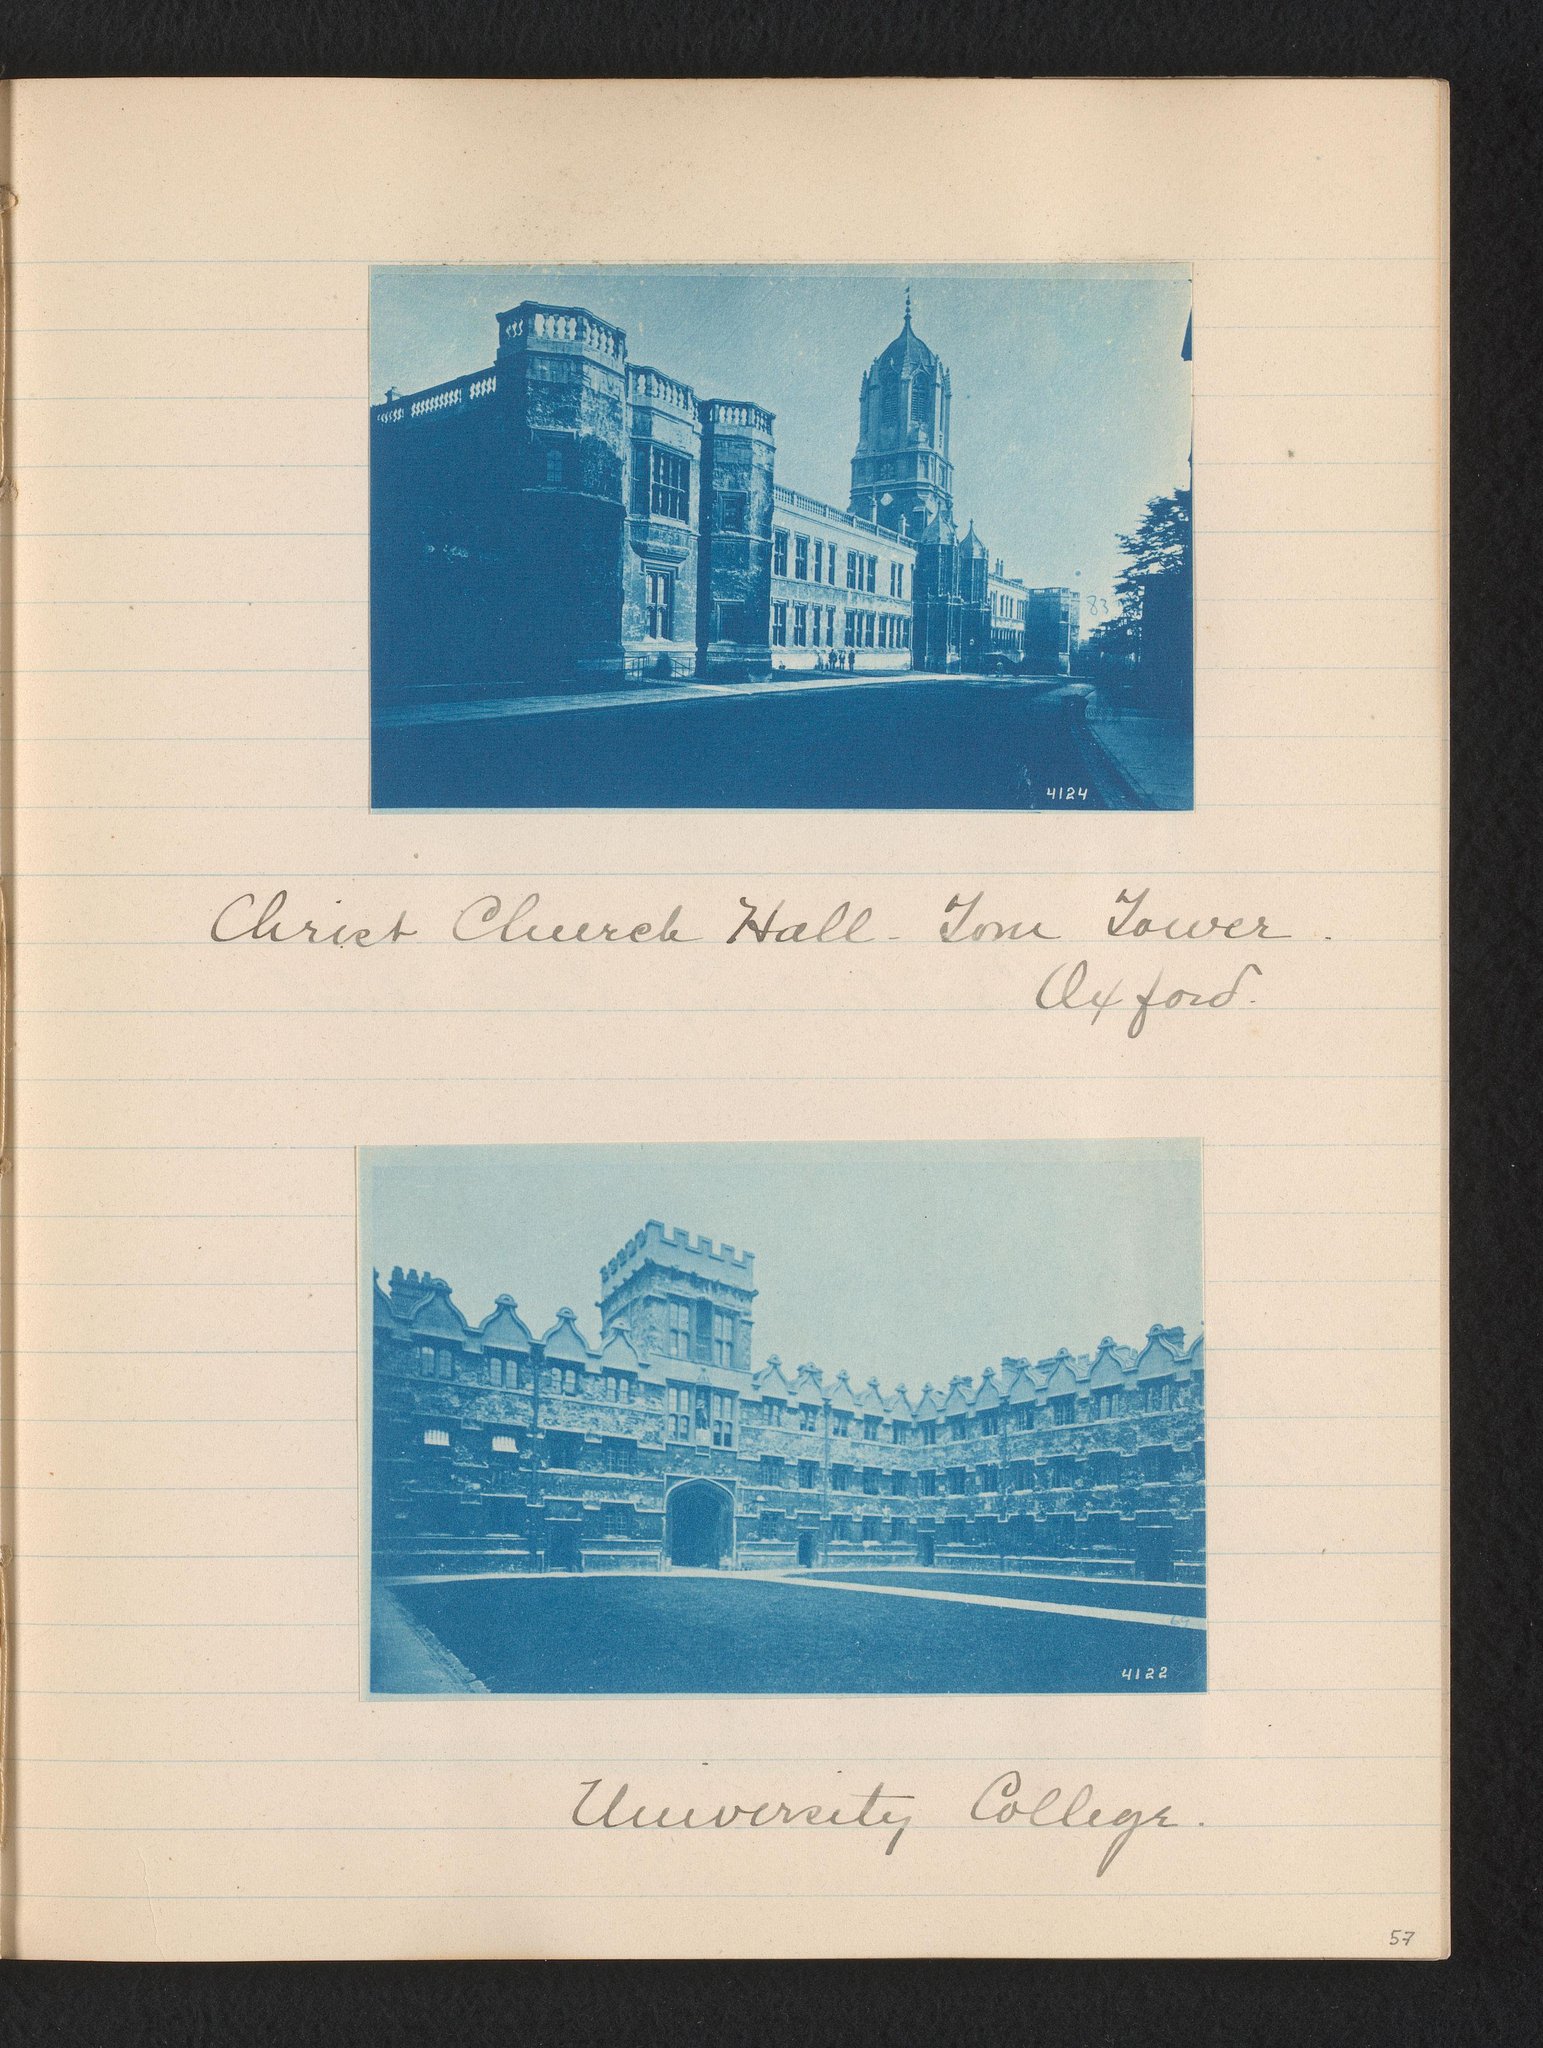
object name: album leaf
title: Twee foto's van Christ Church College en University College, Oxford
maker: Anonymous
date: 1901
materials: paper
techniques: cyanotype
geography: oxford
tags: university building, college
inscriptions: inscription: ‘Christ Church Hall. Tom Tower/ Oxford/ University College’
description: Deze foto's maken deel uit van een album.